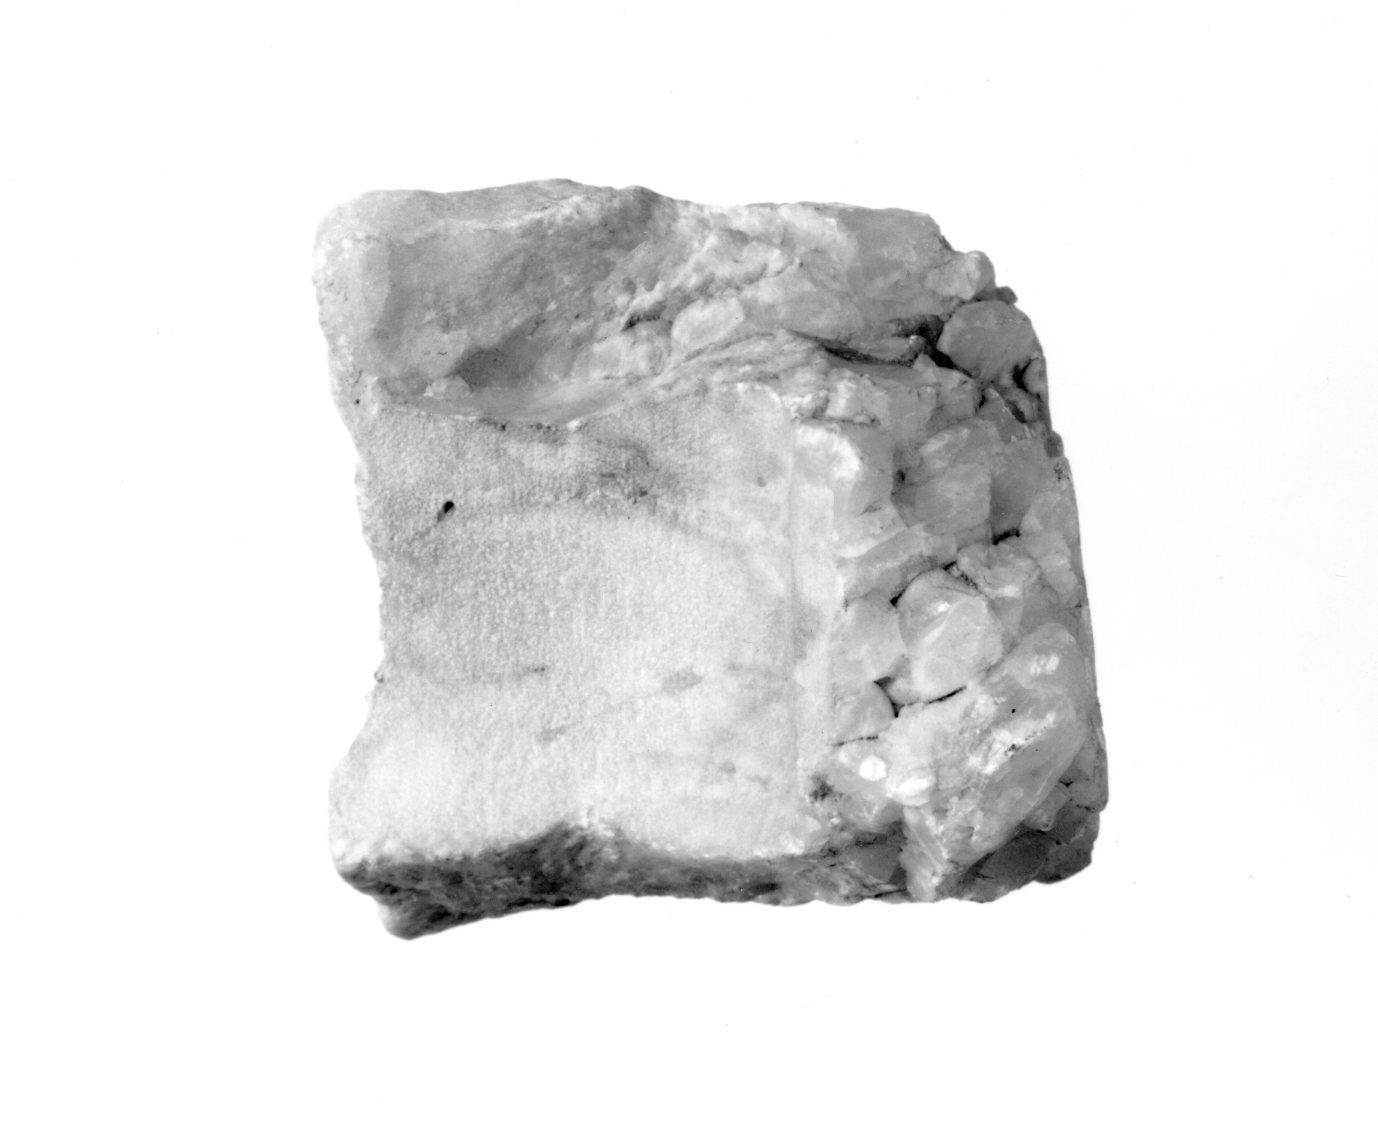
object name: canopic chest, tiye, thutmose iv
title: Fragment of a Canopic Chest of Queen Tiya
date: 1427-1390 BCE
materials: stone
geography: egypt